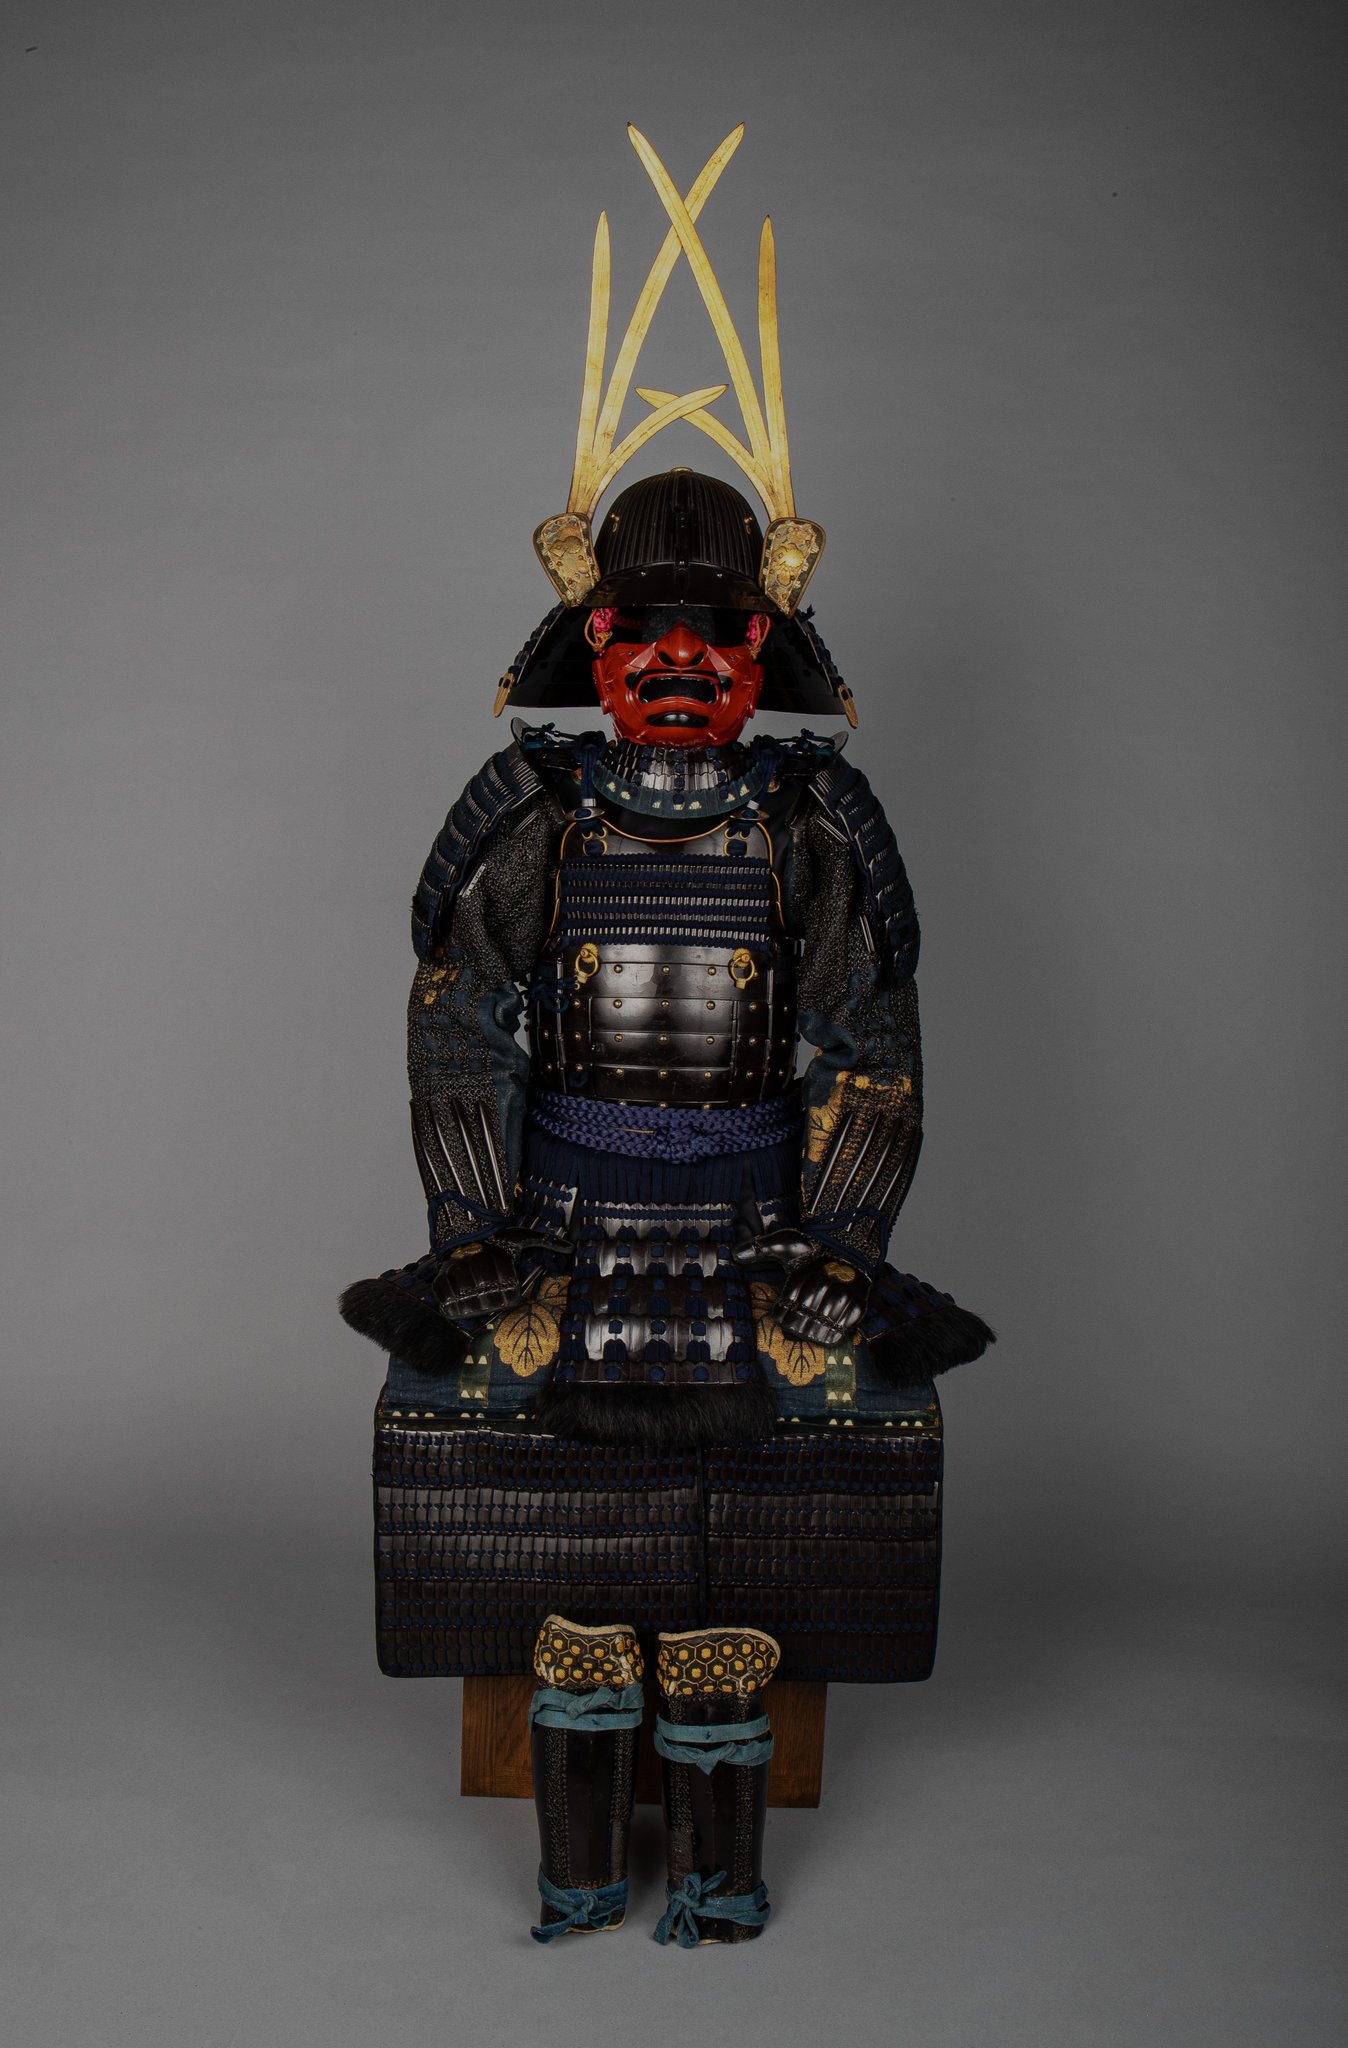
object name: armor i nimai dō gusoku i with box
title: Armor (Rokumai-Dō Gusoku) with Box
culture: japanese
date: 1667-1700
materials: fur, iron, lacquer, leather, textile, wood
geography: japan